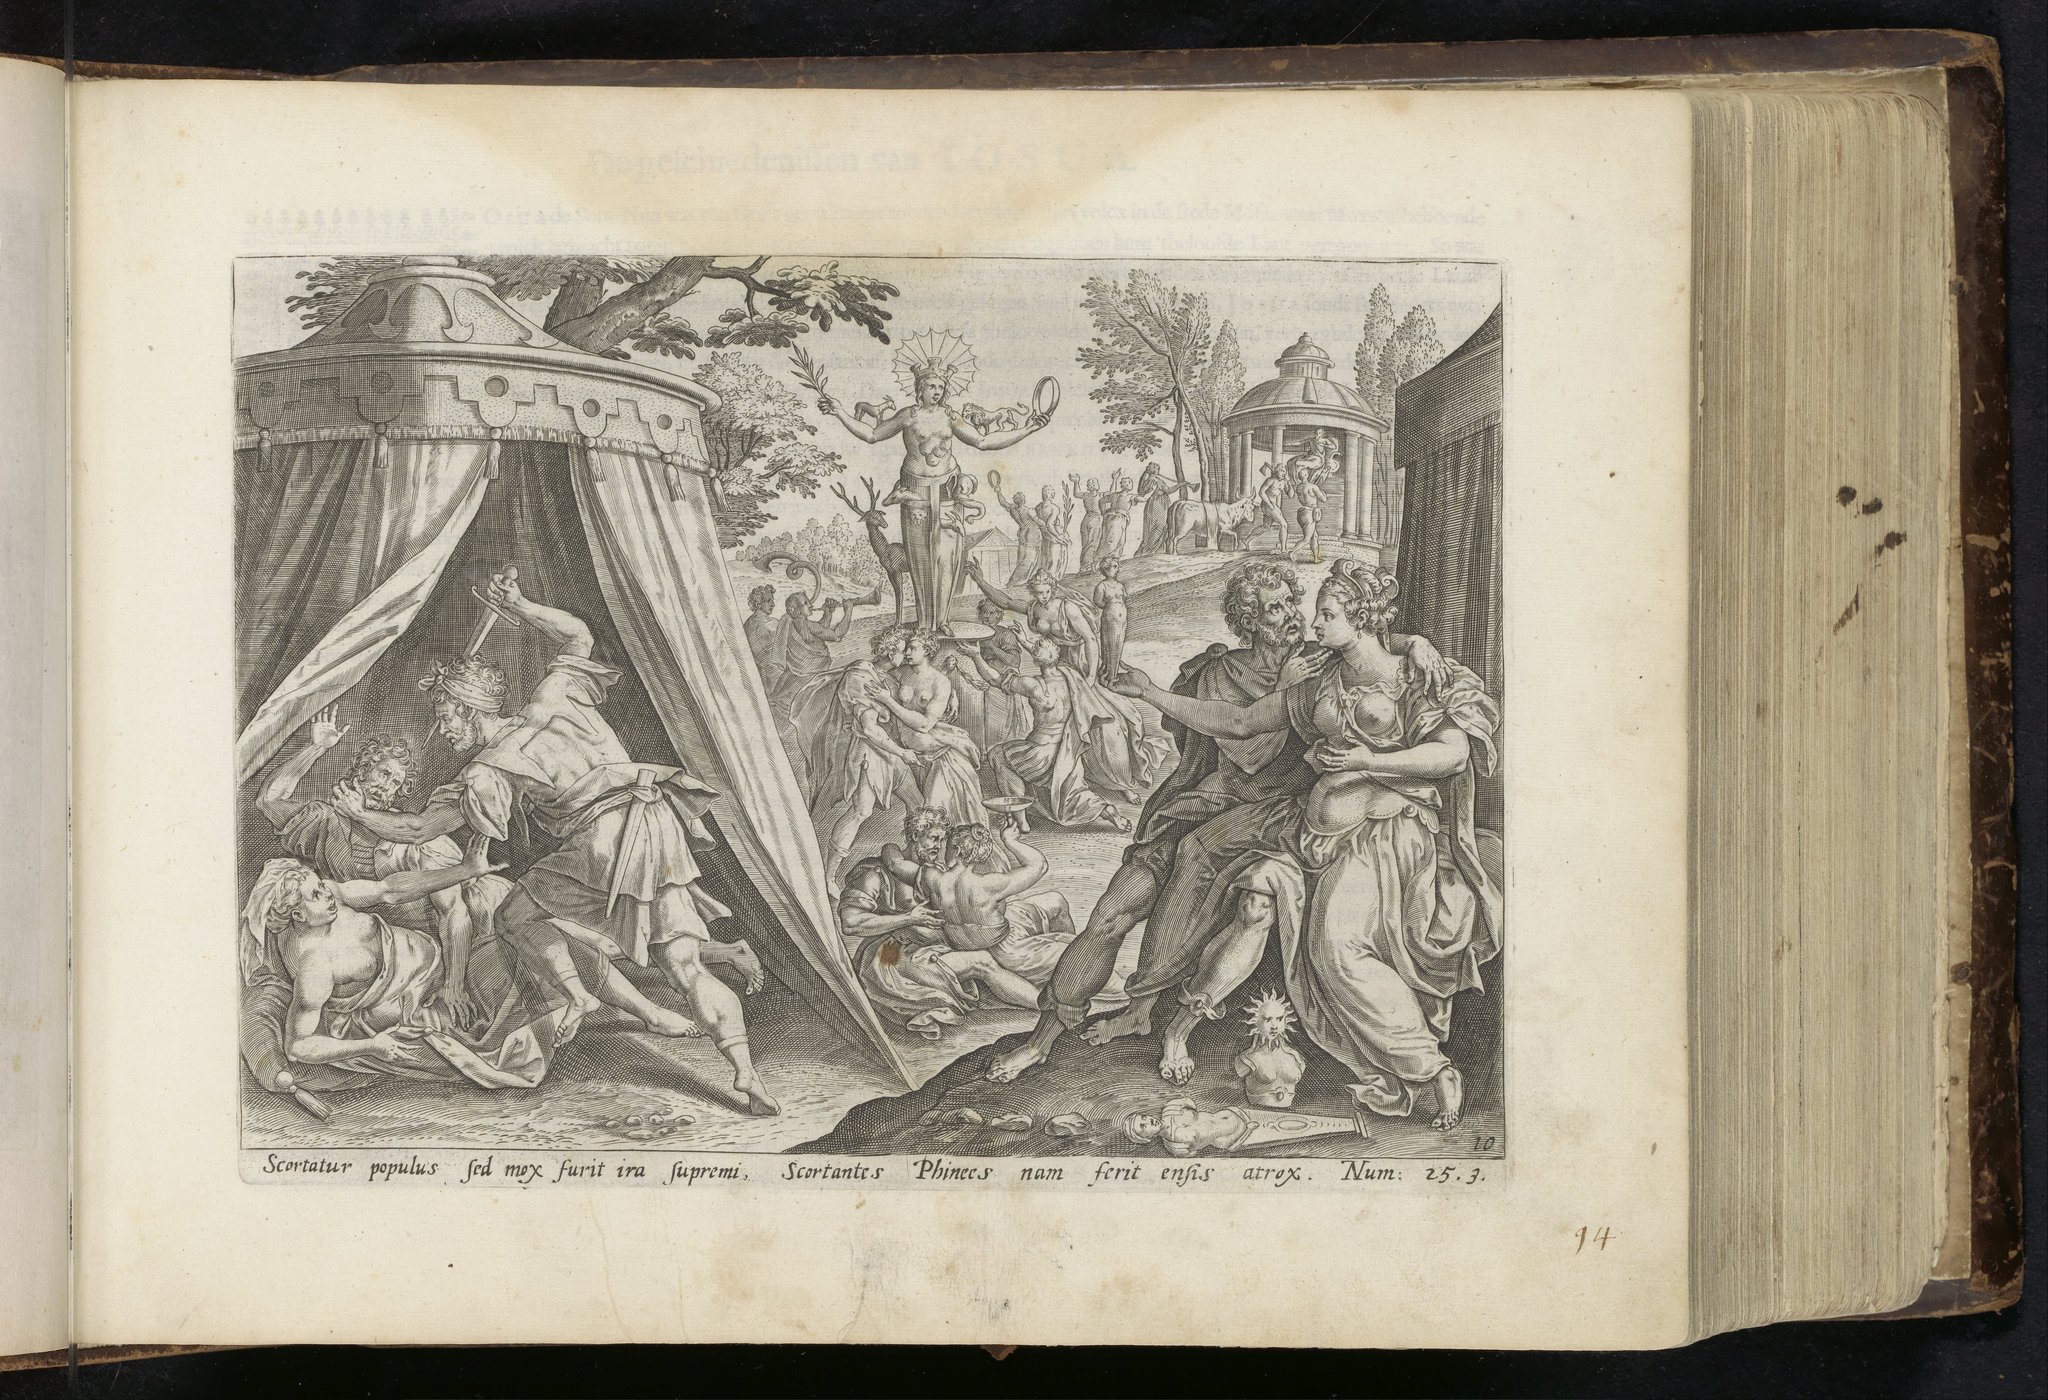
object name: print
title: Den Grooten Figuer-Bibel (...)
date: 1585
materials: paper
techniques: engraving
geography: alkmaar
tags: the moabite women lead the israelites into the worship of baal-peor, the israelites have intercourse with the moabite women, phinehas, eleazar's son, follows zimri and cozbi and drives his spear through both of them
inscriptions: number: ‘94’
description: De Israëlieten gaan om met Moabitische vrouwen en gaan hun god, de Baäl van Peor, vereren. De Israëlieten knielen voor het afgodsbeeld neer en doen op de achtergrond mee aan offerplechtigheden. Mozes had opgedragen alle vereerders van de Baäl te doden. Op de voorgrond geeft Pinechas gehoor aan deze opdracht door de Israëliet Zimri en de Midjanitische vrouw Kozbi, die in een tent liggen te vrijen, te doden. Onder de voorstelling een verwijzing in het Latijn naar de Bijbeltekst in Num. 25:3. Deze prent maakt deel uit van een album.